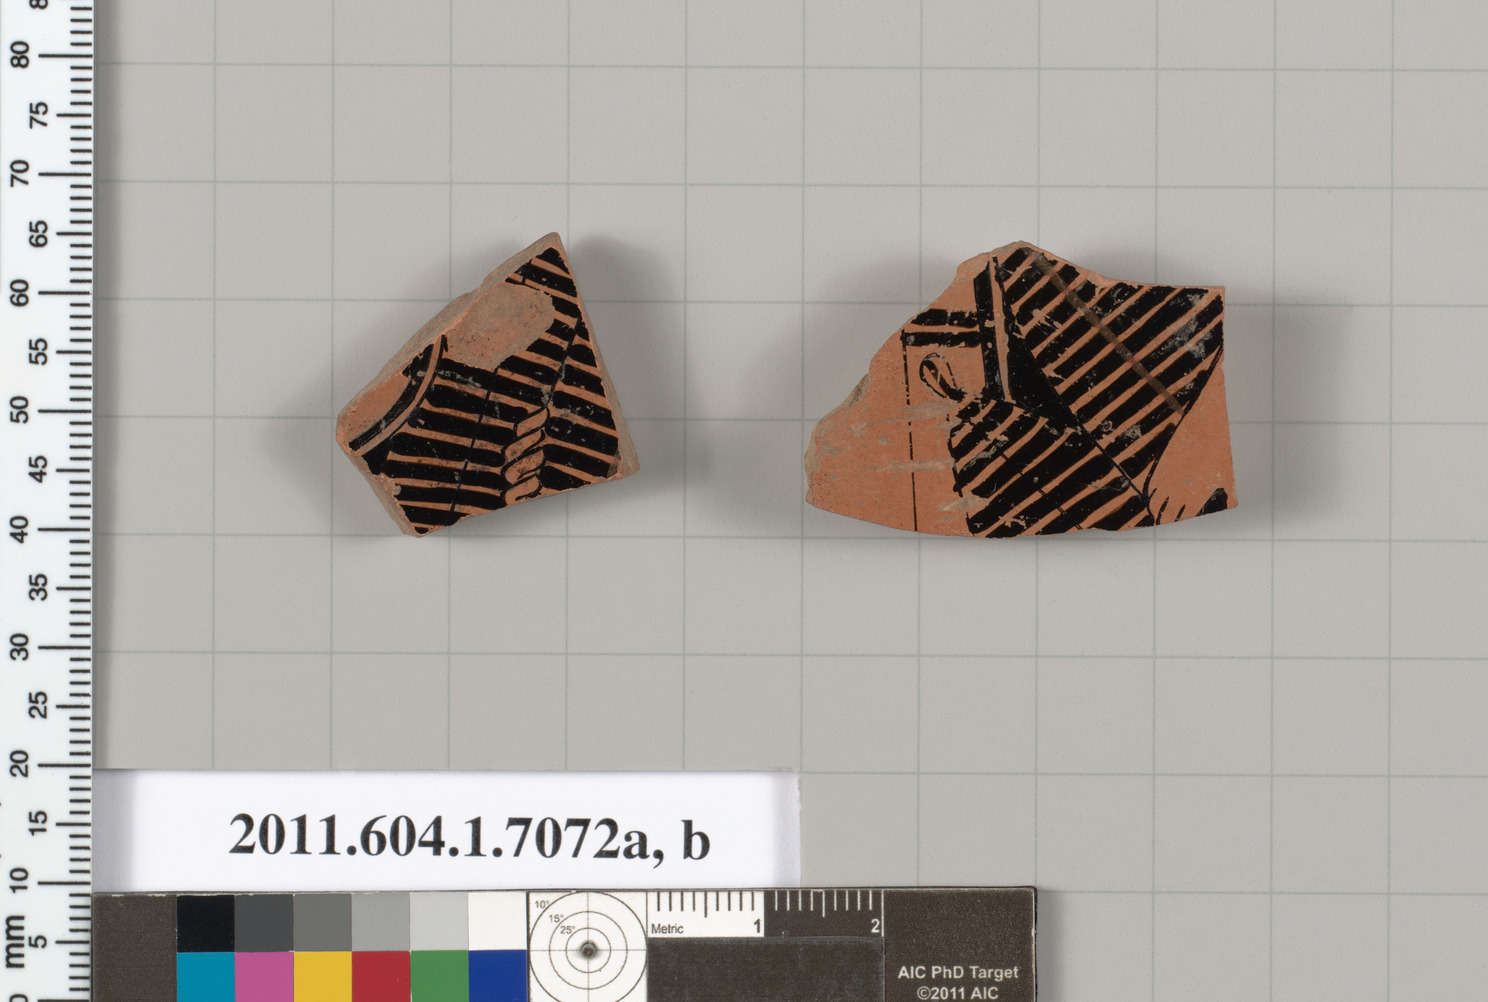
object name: kylix fragment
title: Terracotta fragments of a kylix (drinking cup)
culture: greek, attic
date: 500-480 BCE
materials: terracotta